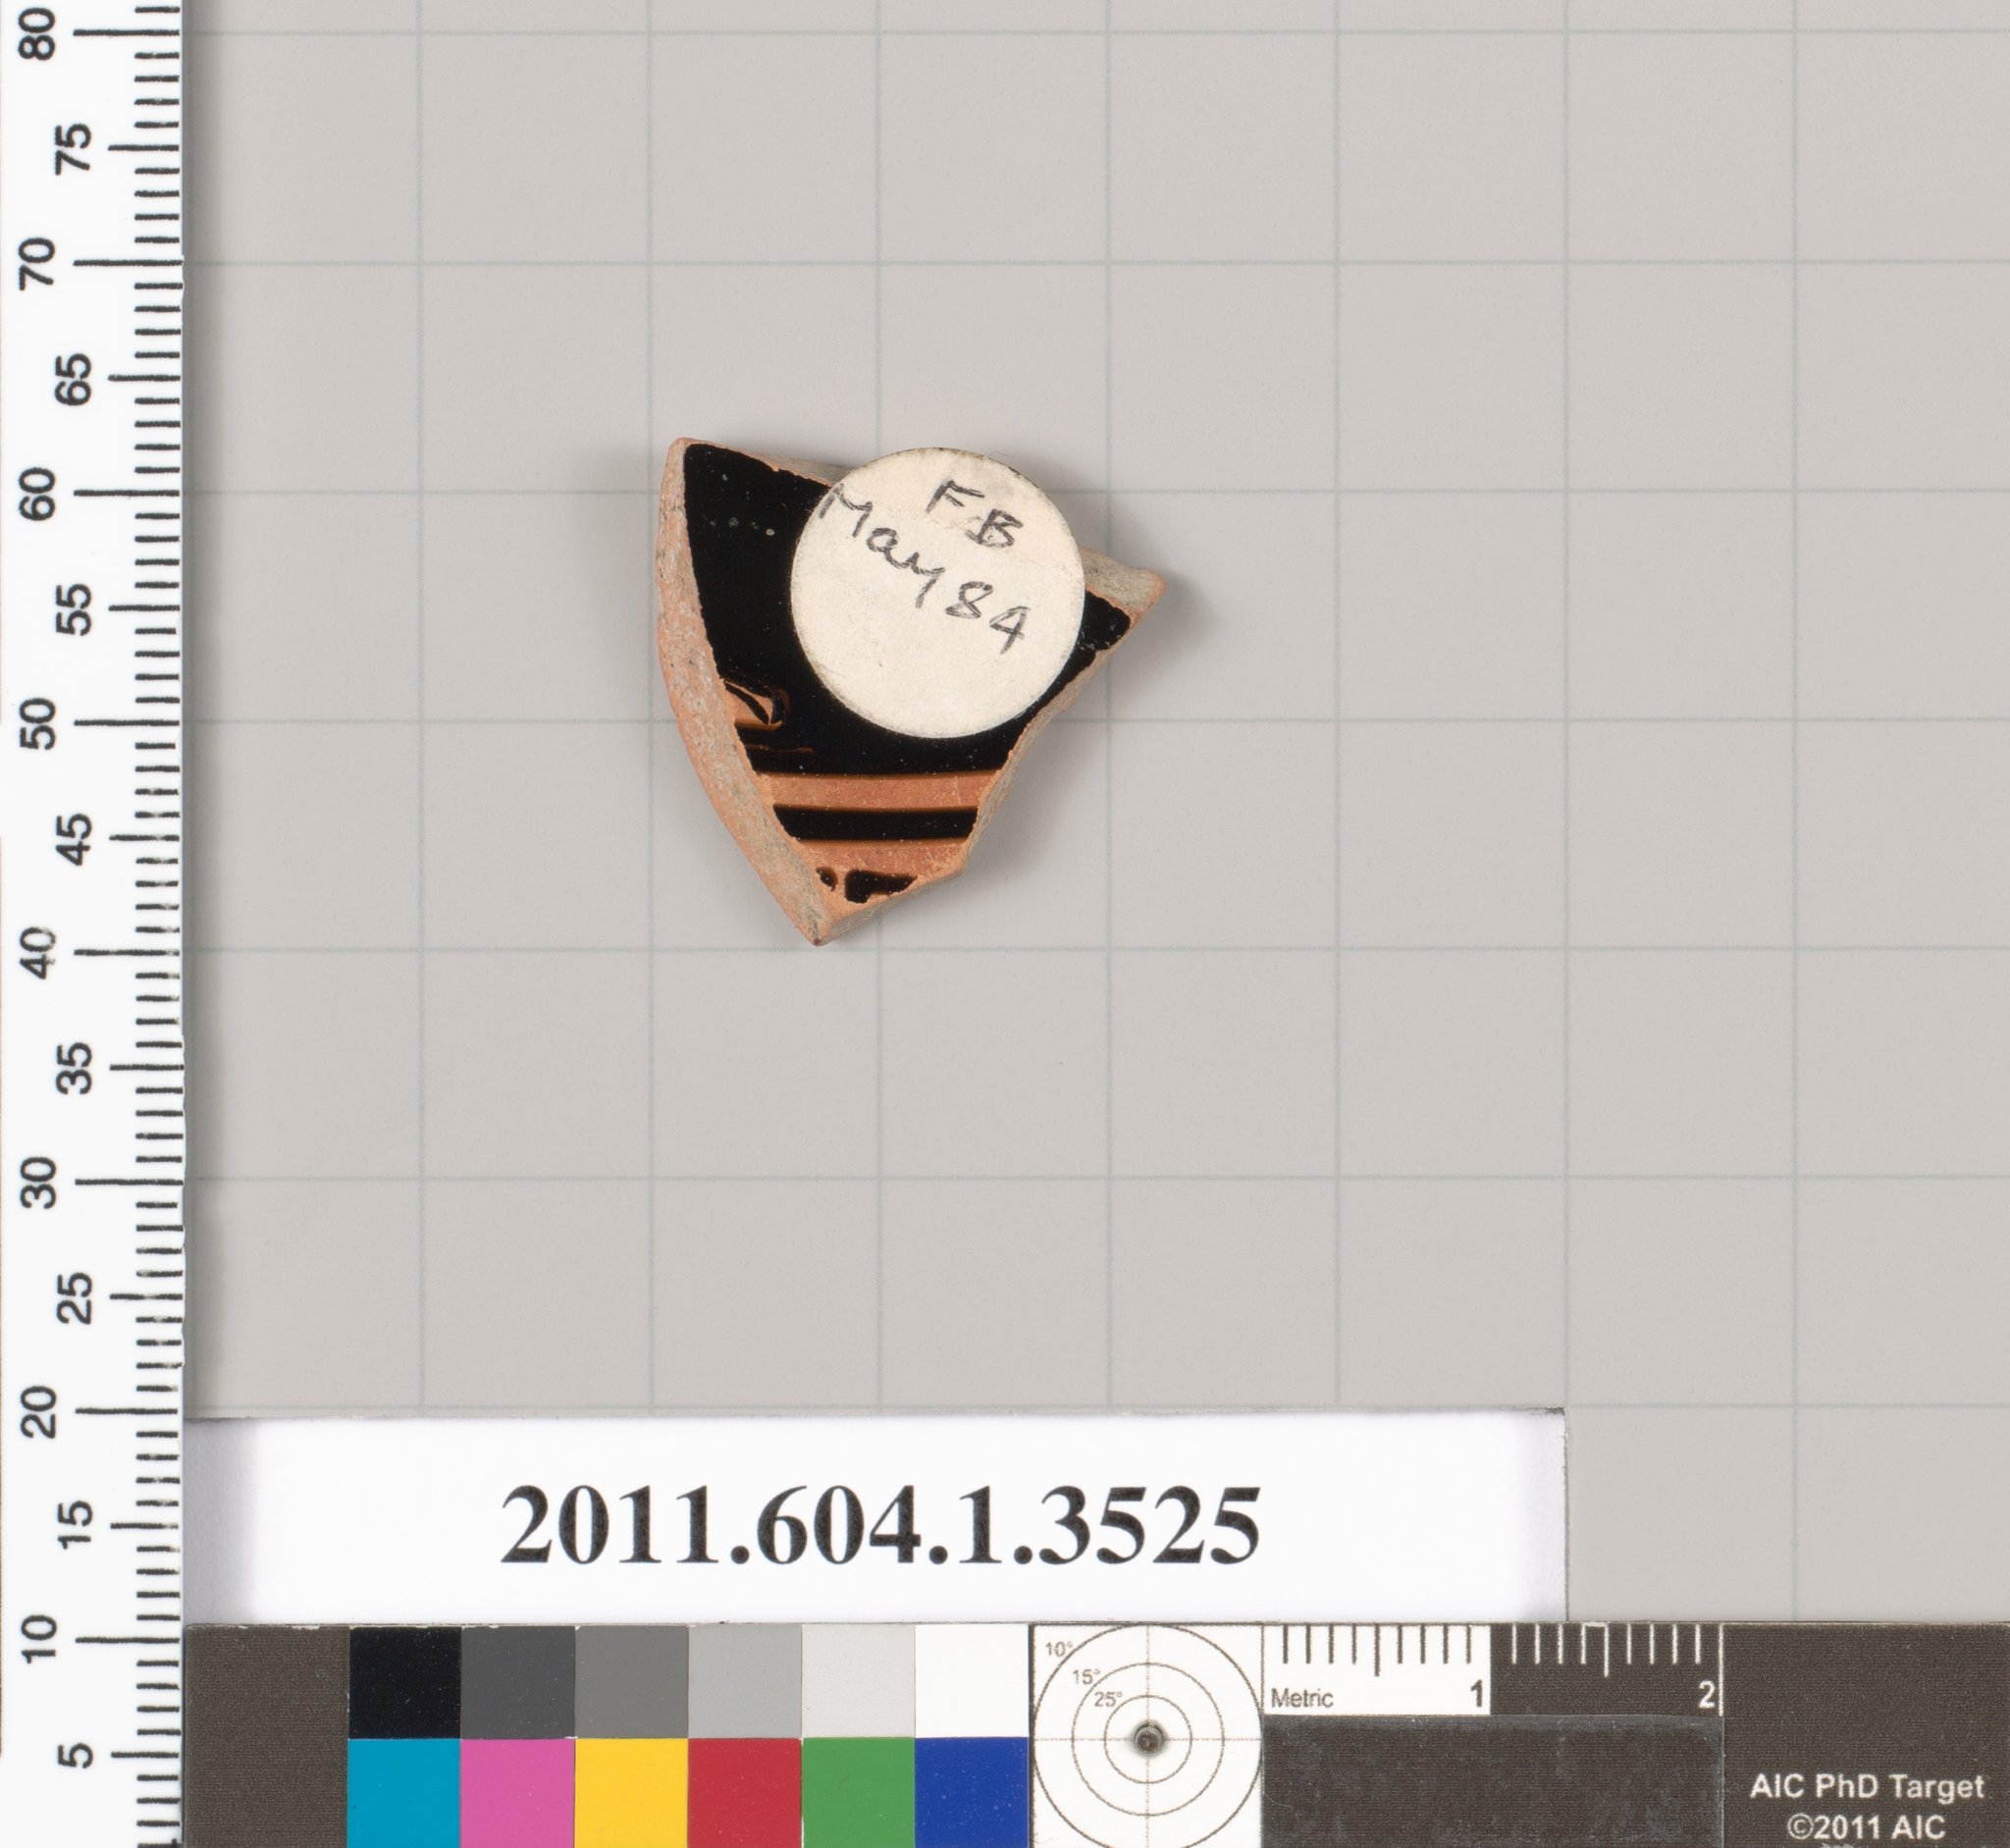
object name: kylix fragment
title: Terracotta fragment of a kylix (drinking cup)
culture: greek, attic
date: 475-451 BCE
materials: terracotta